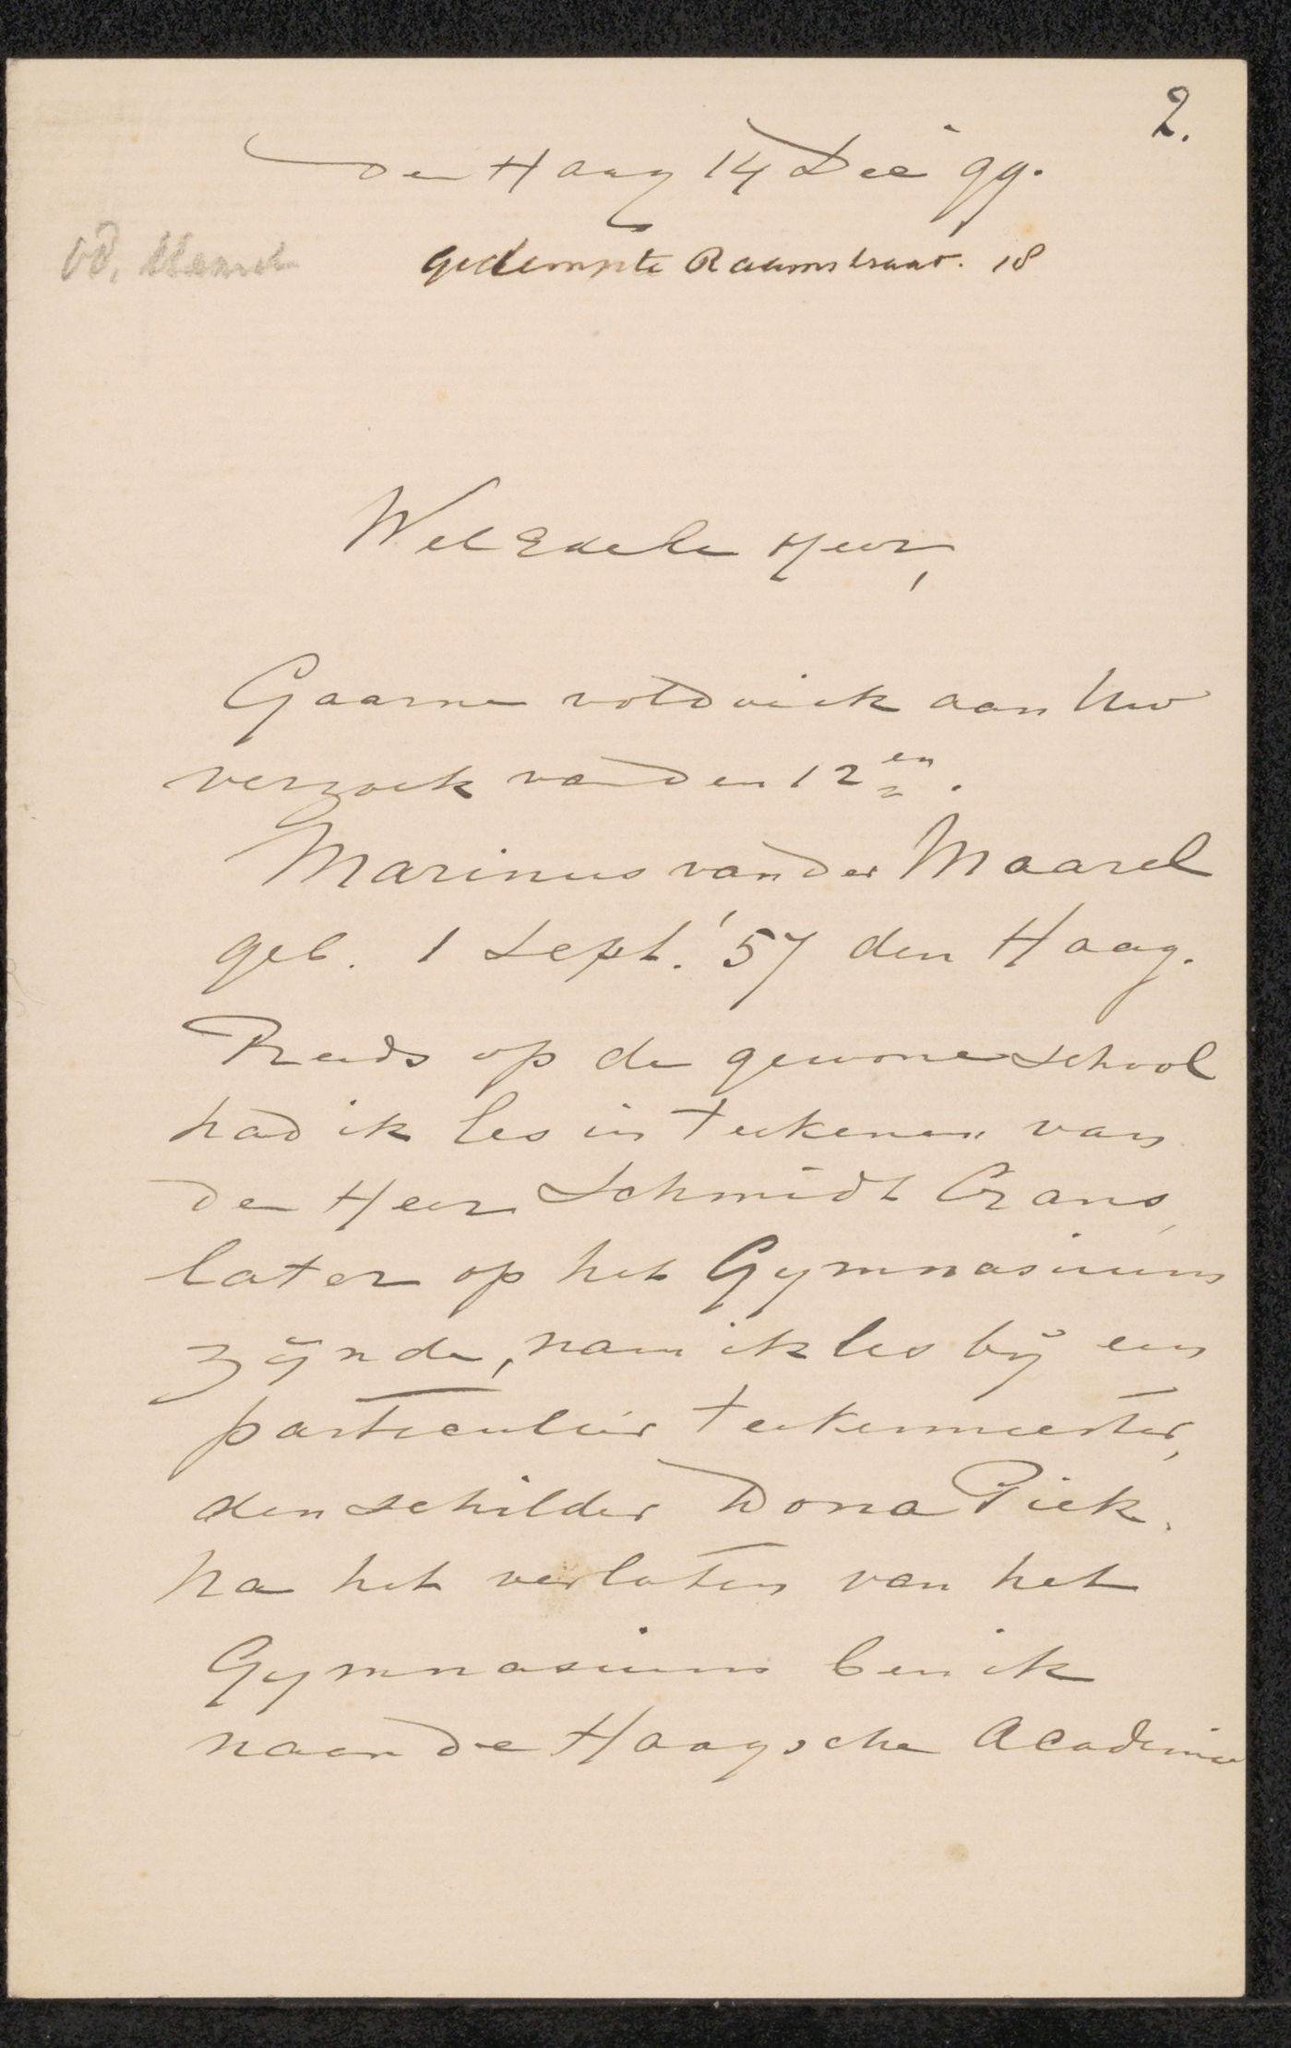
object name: letter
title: Brief aan Pieter Haverkorn van Rijsewijk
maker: marinus van der maarel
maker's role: draughtsman, painter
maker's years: 1857-1921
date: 1899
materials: ink, paper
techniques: pen, writing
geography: the hague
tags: antonie franciscus dona, willem maris, rotterdam, print maker, johan michaël schmidt crans, pieter haverkorn van rijsewijk, distribution of awards ~ art contest, education, tuition of the artist (in general), painting (including book-illumination, miniature-painting)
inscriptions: watermark